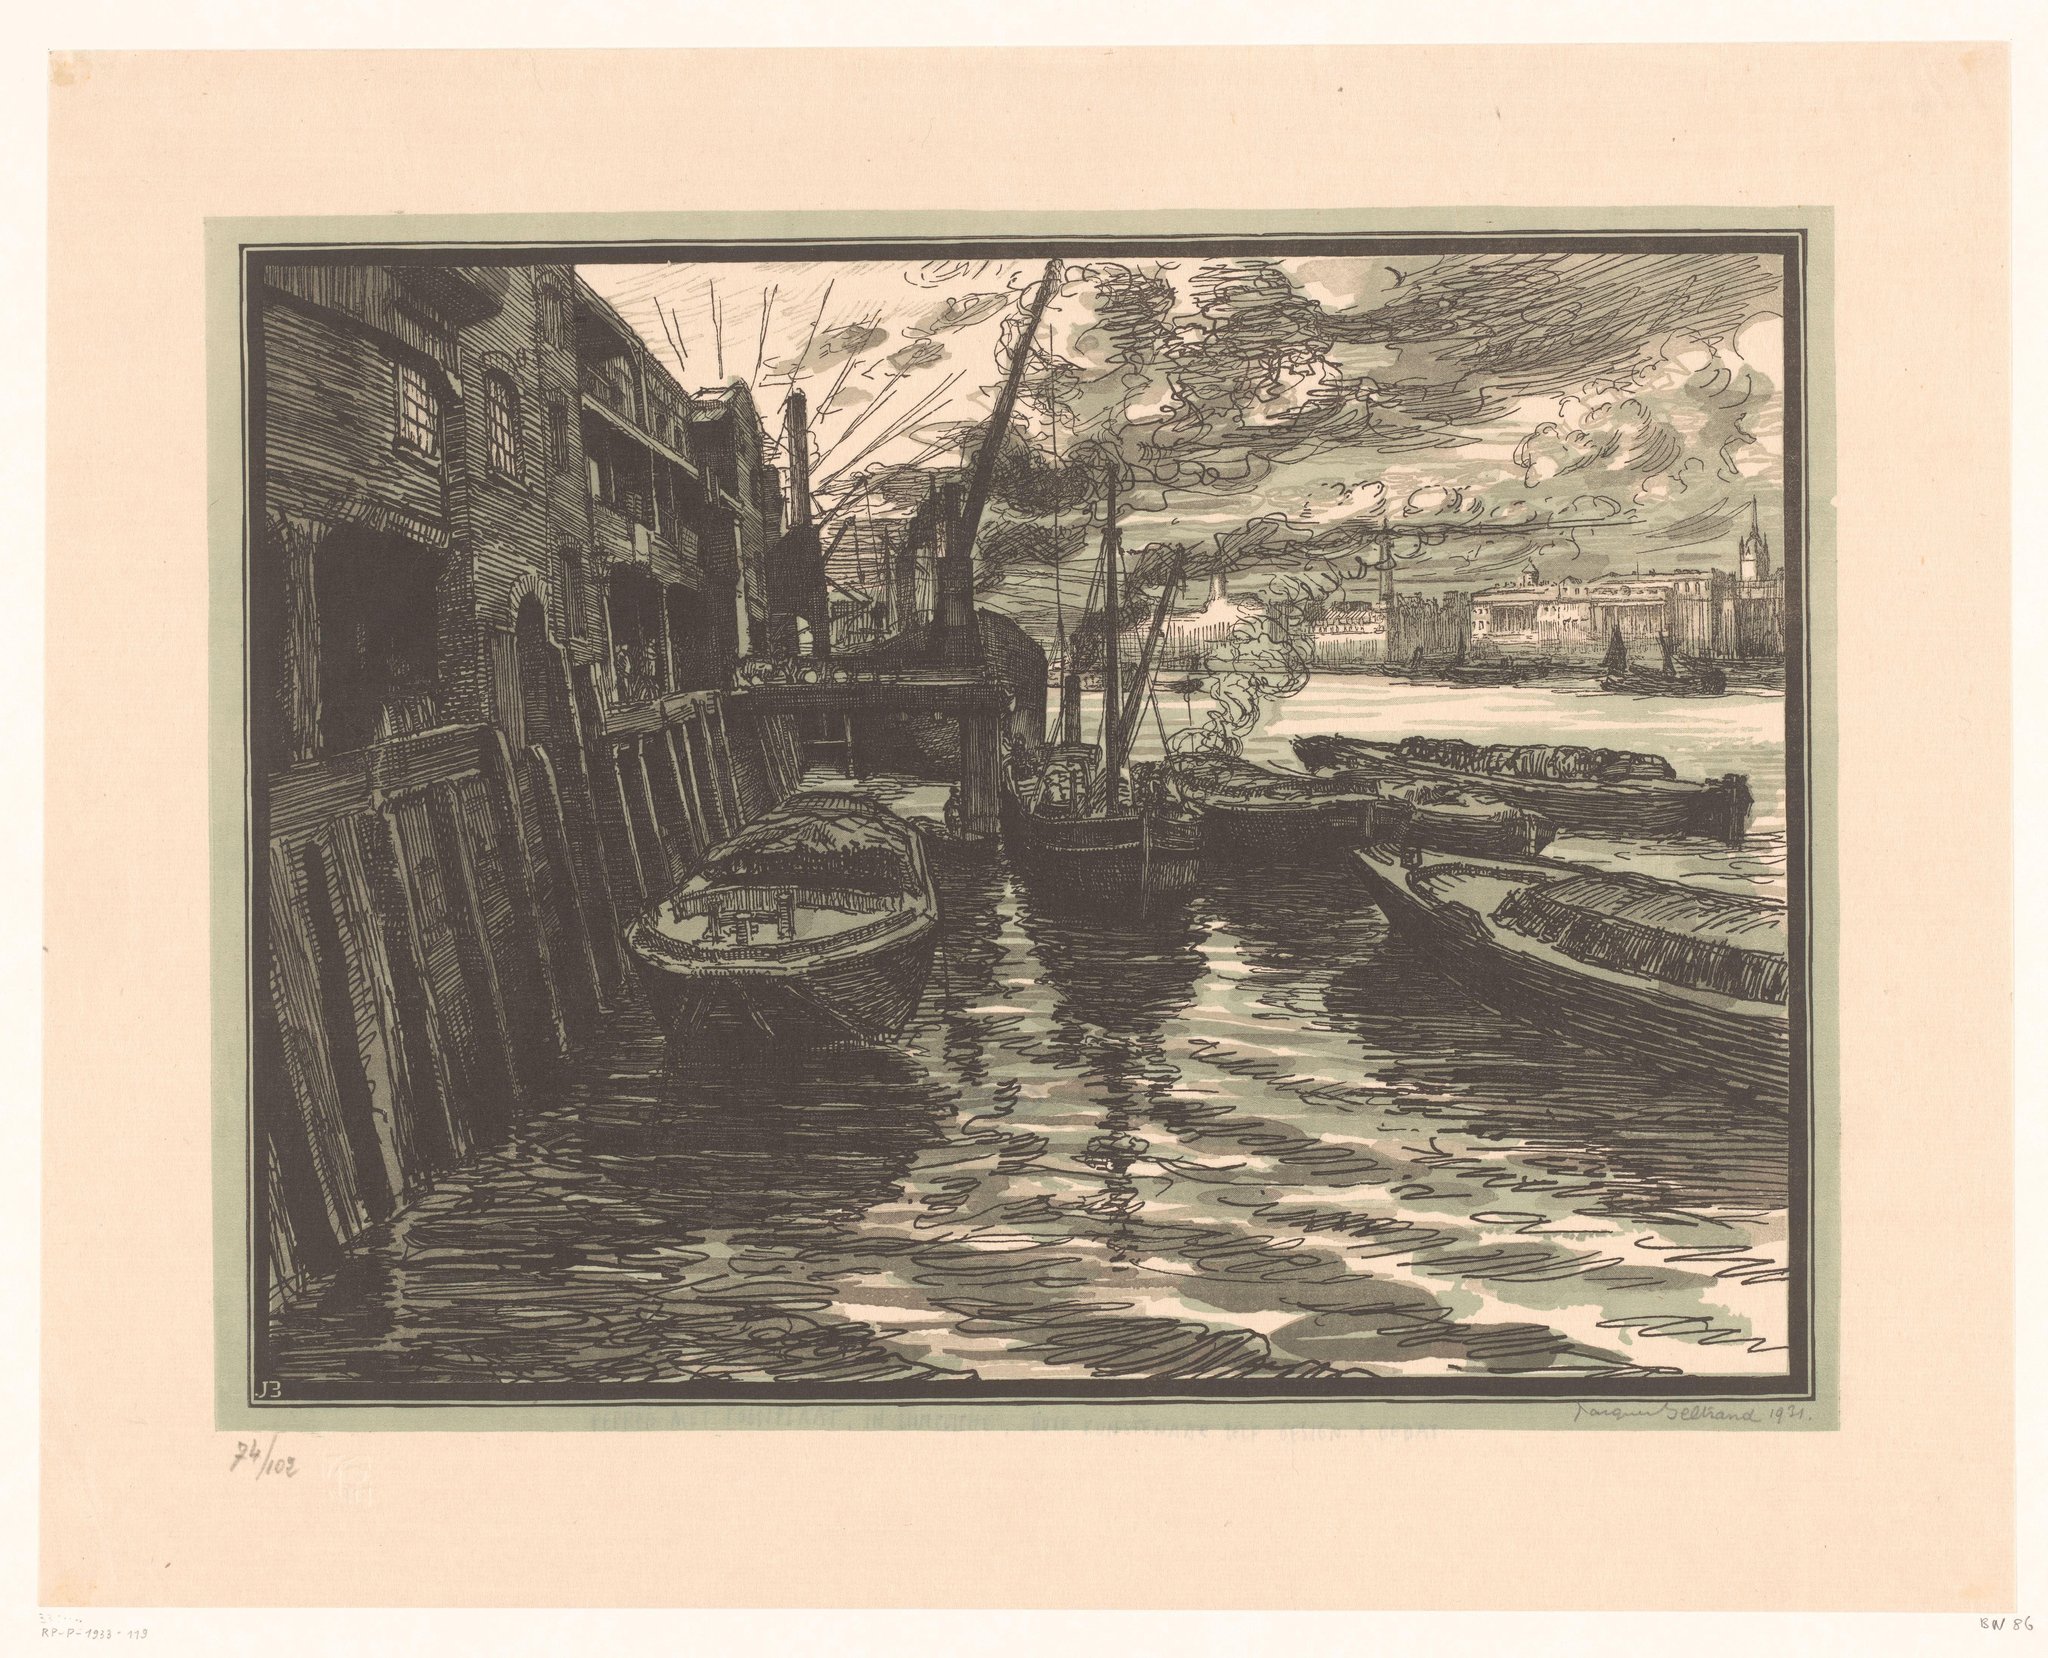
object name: print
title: Sloepen op de Theems in Londen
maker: jacques beltrand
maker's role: print maker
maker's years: 1874-1977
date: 1931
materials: paper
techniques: line block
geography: france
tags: river, ships (in general), london, thames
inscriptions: check stamp: Lugt 1195a, collector's mark: Lugt 2228